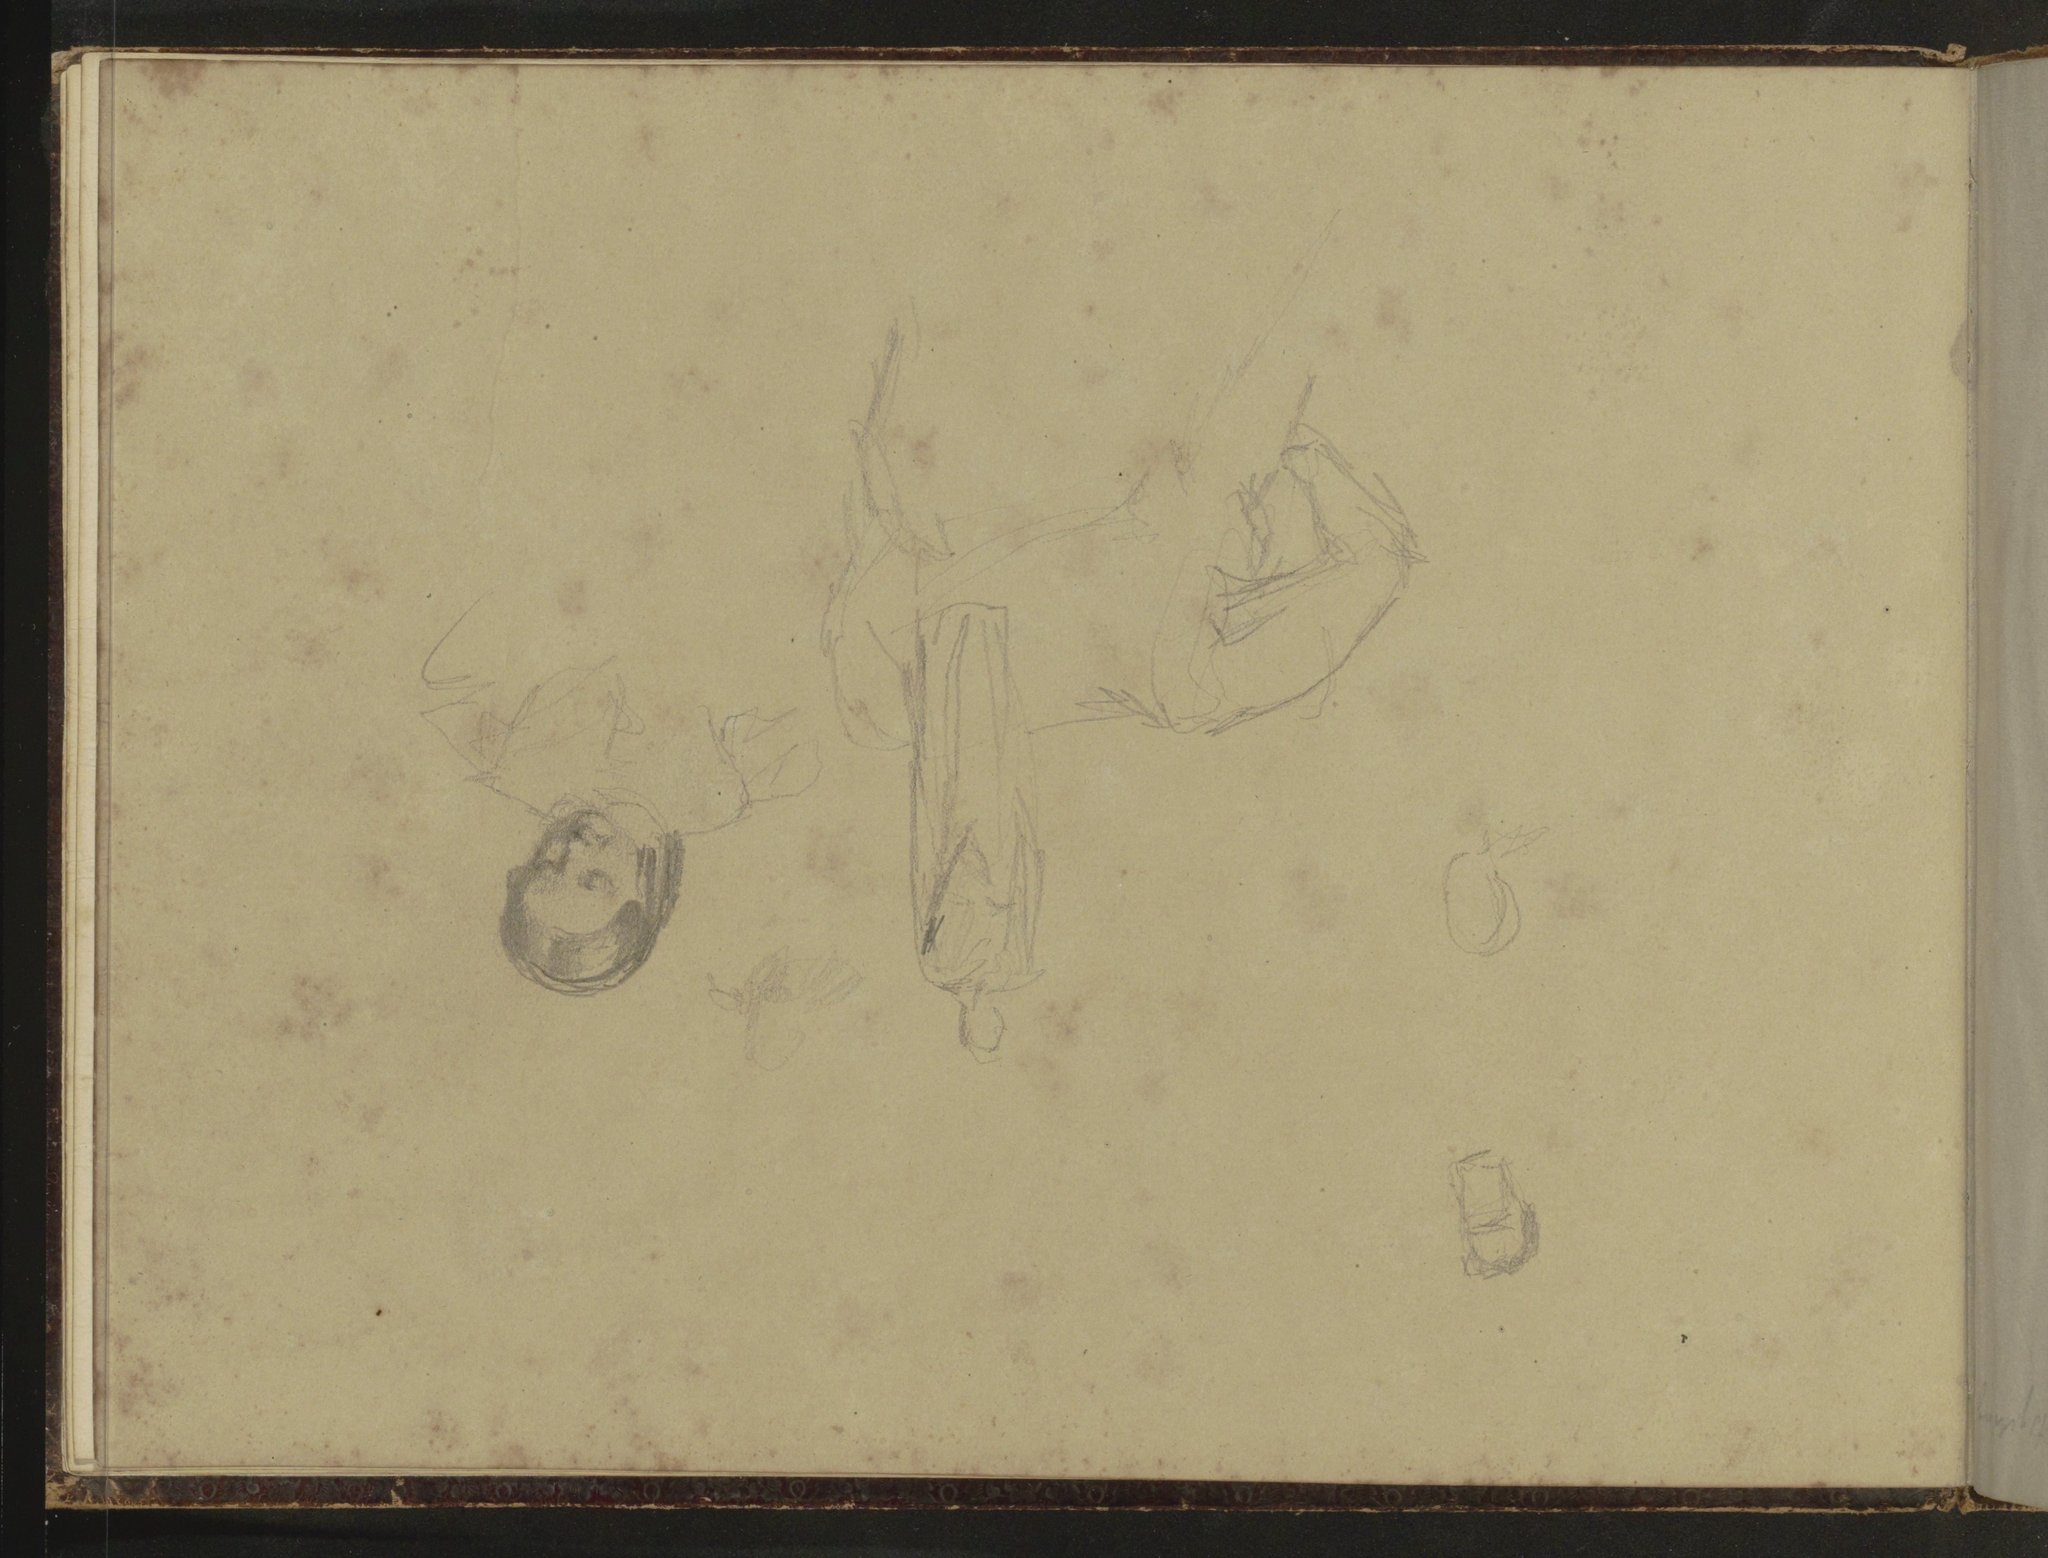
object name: sketchbook leaf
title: Paard, een staande figuur in een mantel en koppen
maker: reinier craeyvanger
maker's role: draughtsman, print maker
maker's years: 1812-1880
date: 1822-1880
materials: paper, pencil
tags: head (human), standing figure, horse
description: Blad 7 verso uit een schetsboek met 45 bladen.